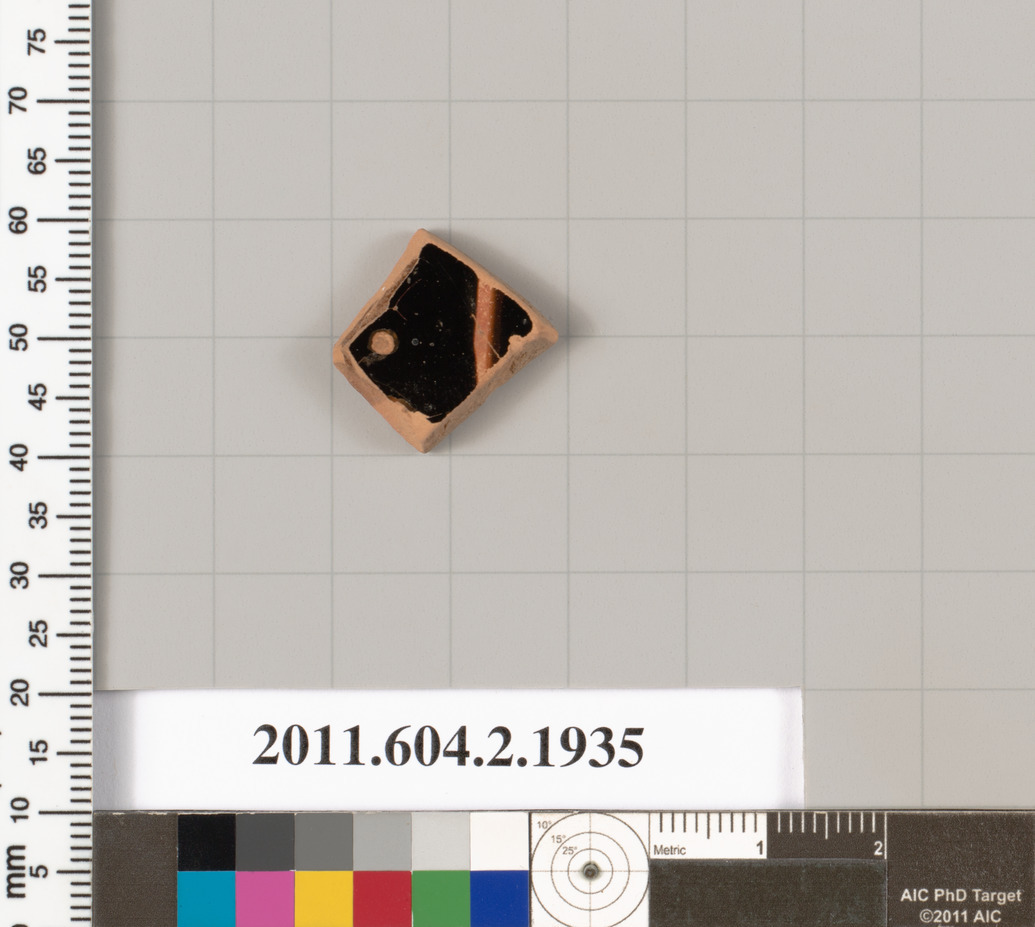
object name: skyphos fragment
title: Terracotta fragment of a skyphos (deep drinking cup)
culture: greek, attic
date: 500-401 BCE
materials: terracotta